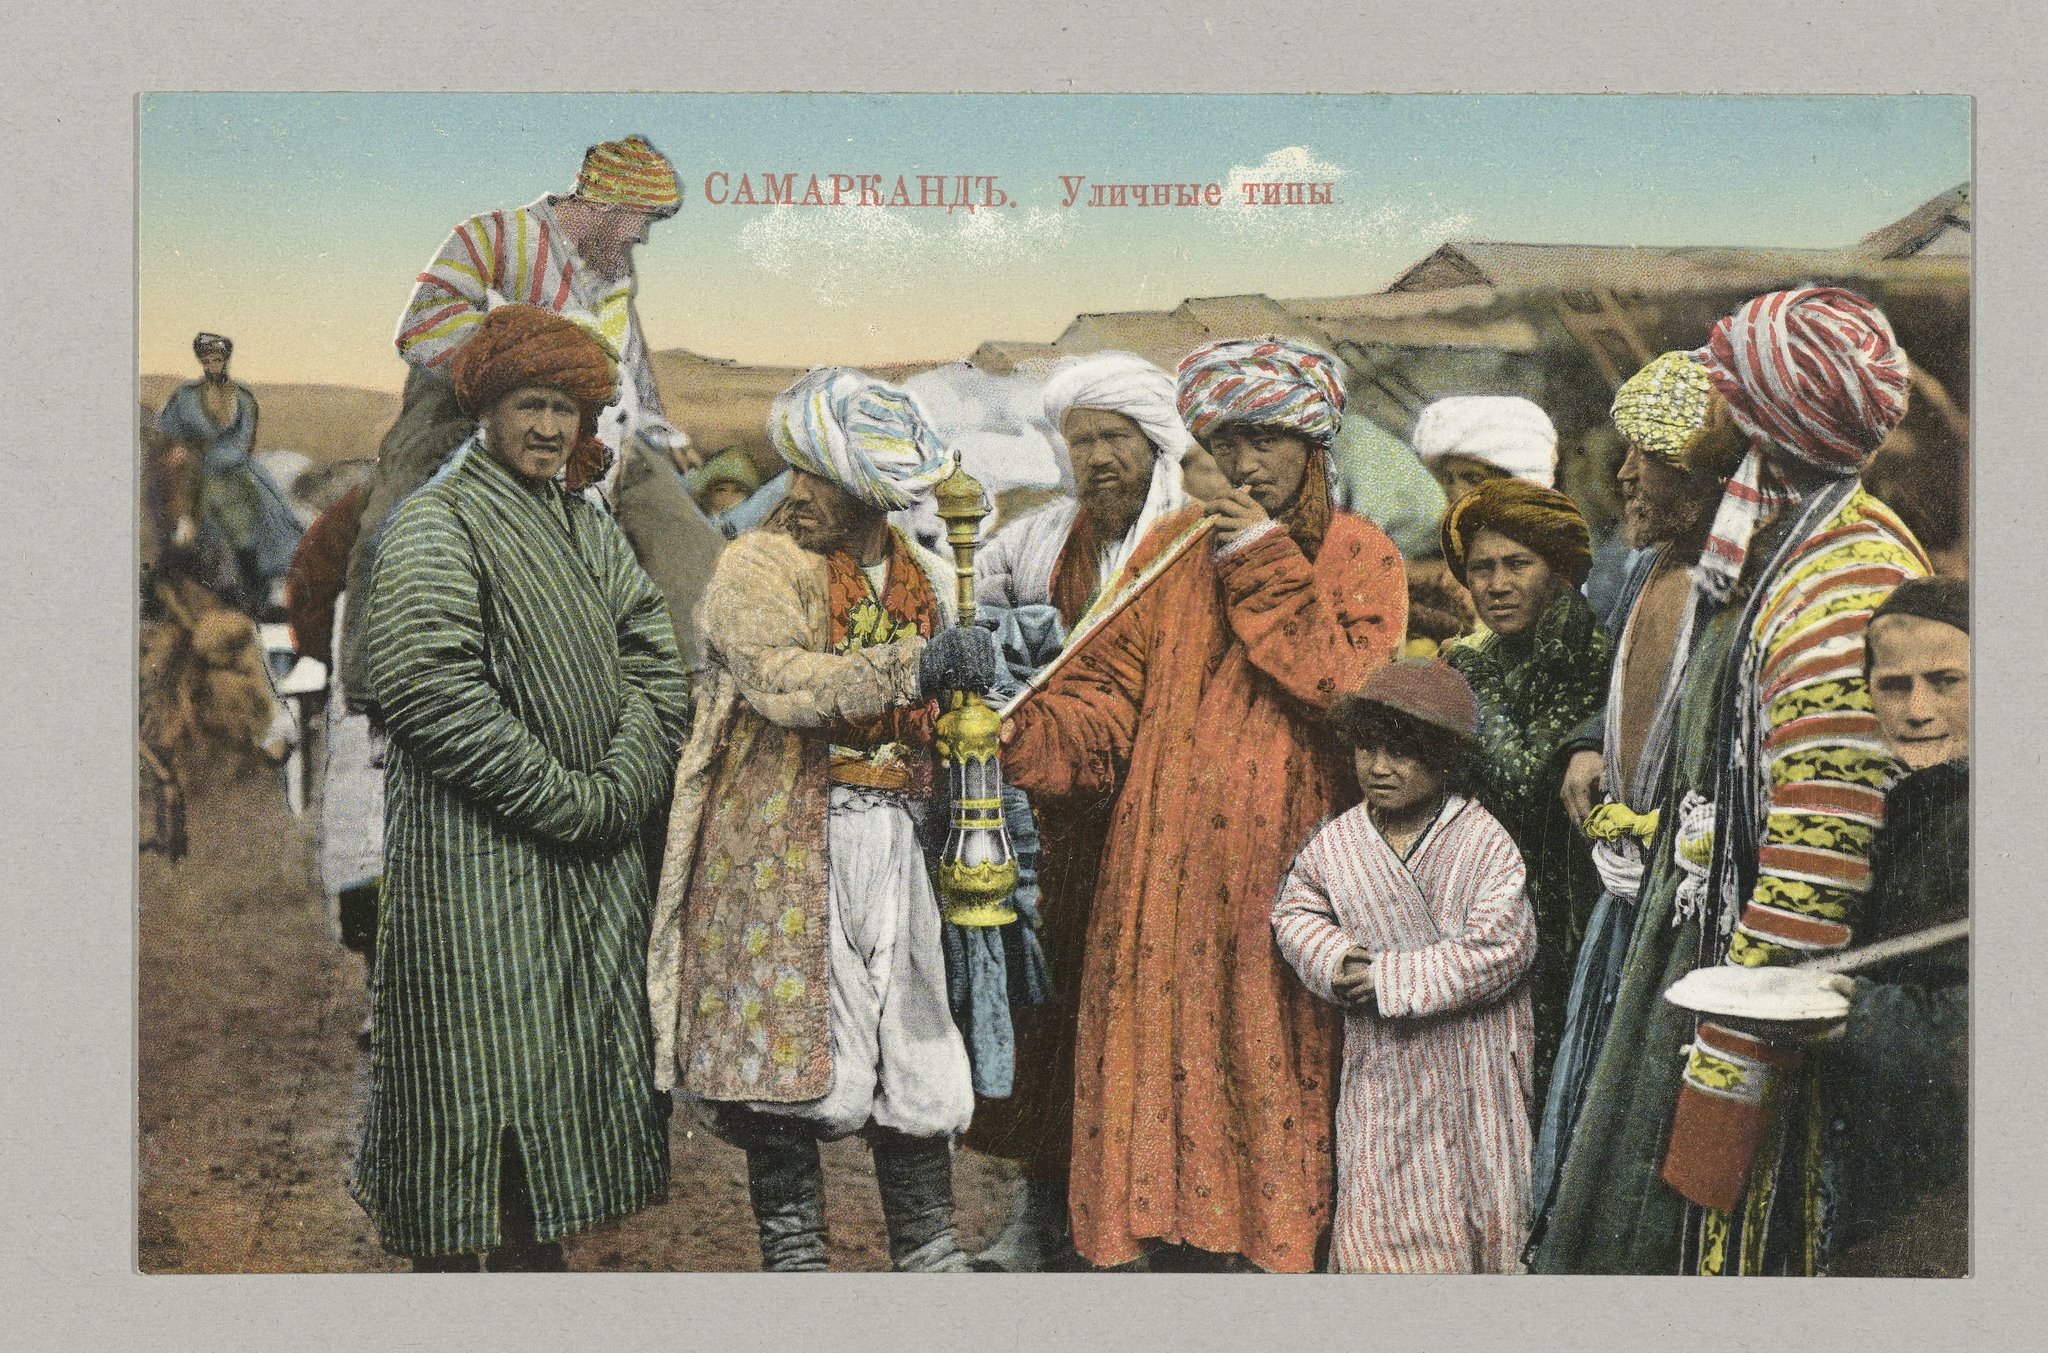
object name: photomechanical print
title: Groep Oezbekistanen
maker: Anonymous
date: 1895-1915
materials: cardboard, paper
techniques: photograph, lithograph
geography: samarqand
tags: samarqand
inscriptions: number: ‘23.’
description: Groep mensen op straat, bovenaan staat een titel in het Oezbeeks.